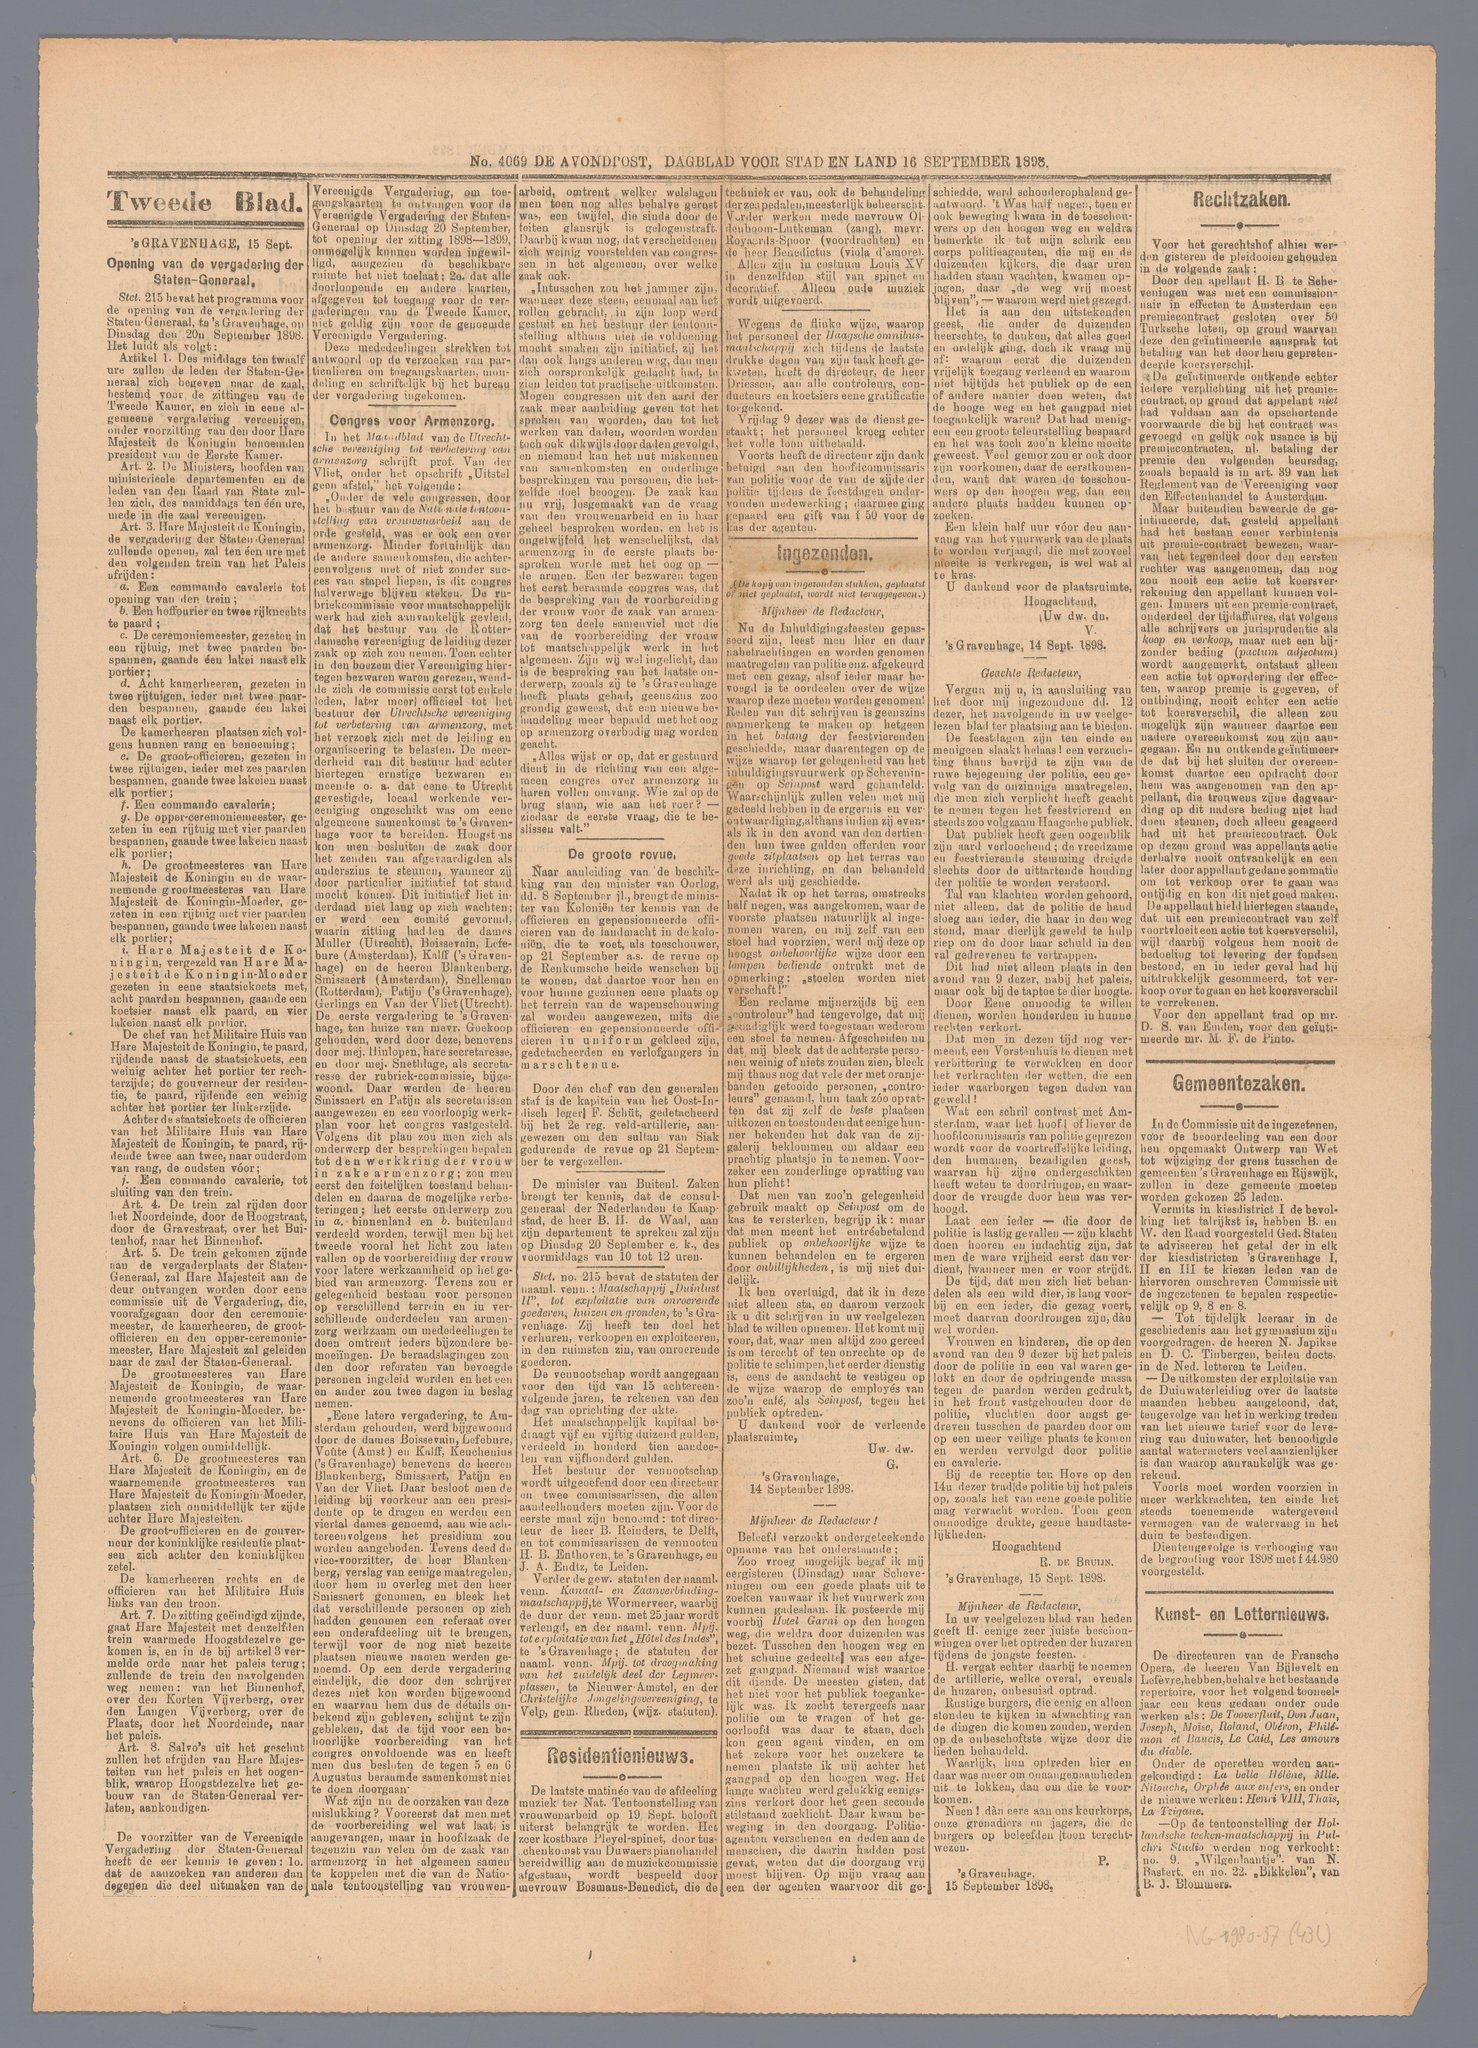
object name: newspaper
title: de Avondpost; dagblad voor stad en land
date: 1898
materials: paper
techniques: printing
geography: the hague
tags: wilhelmina of the netherlands, netherlands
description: Eén van een serie kranten, nrs. 4056 t/m 4073, van "de Avondpost" met berichten over de inhuldiging van koningin Wilhelmina 1898.